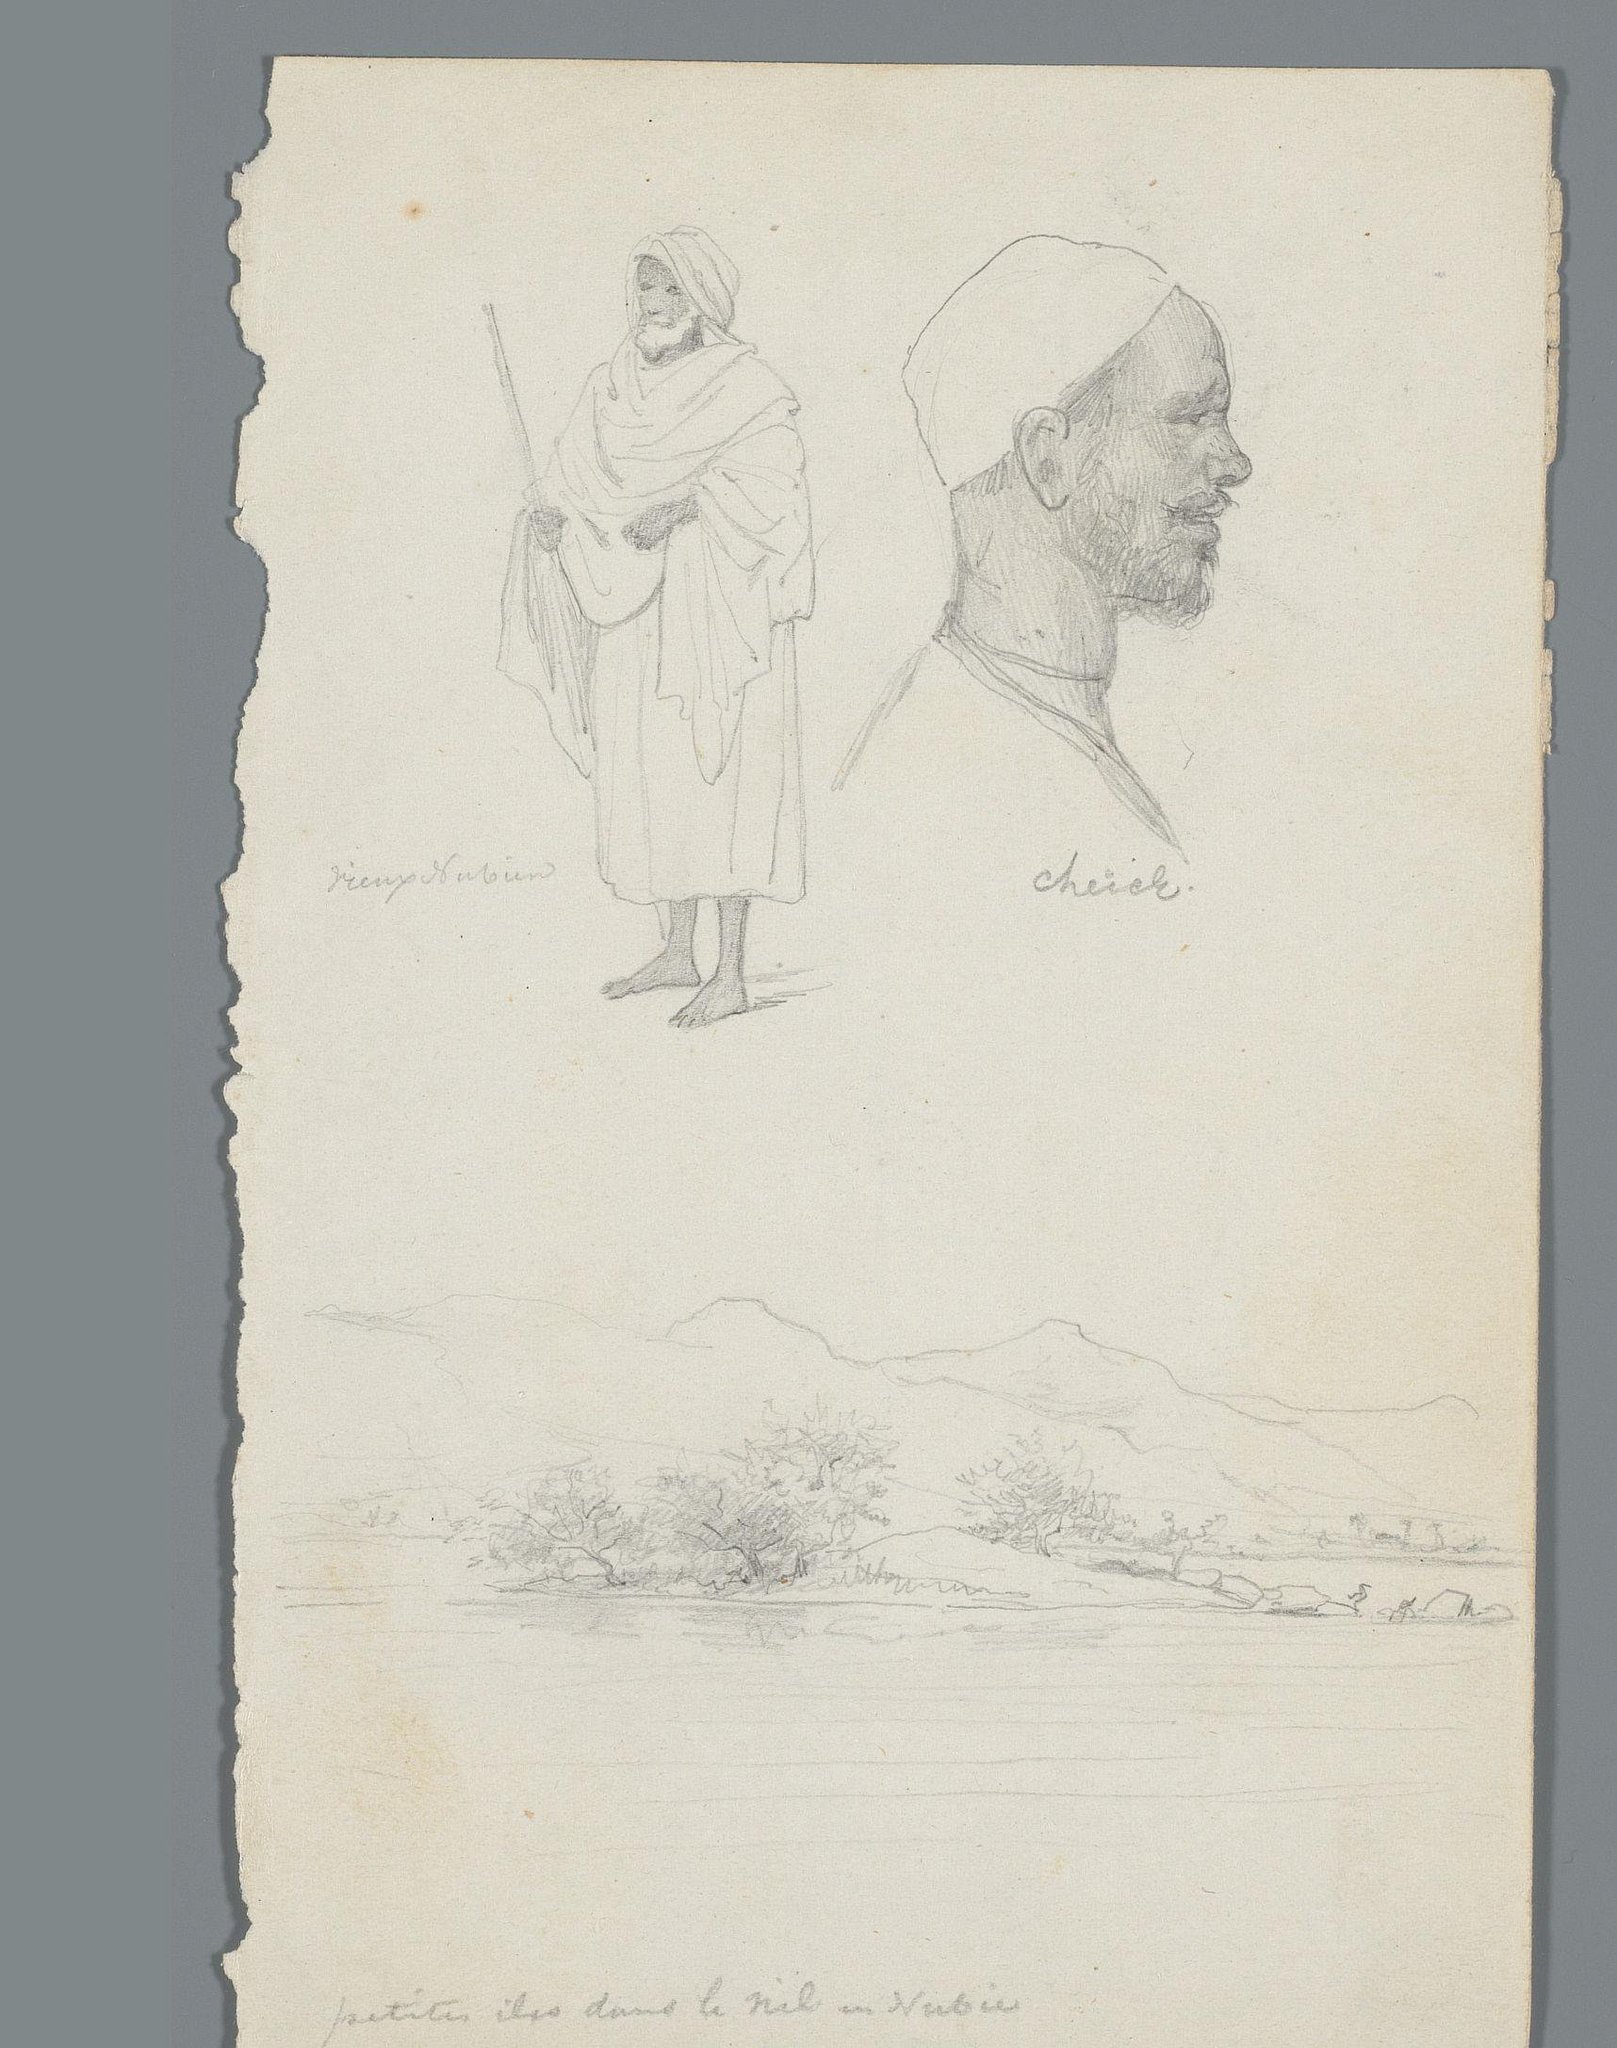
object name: drawing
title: Egyptische reis van 1858-1859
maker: willem de famars testas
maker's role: draughtsman, painter, print maker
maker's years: 1834-1896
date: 1858-1859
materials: paper, pencil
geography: egypt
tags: coast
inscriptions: inscription: ‘vieux Nubien / cheick / petites iles dans le Nil en Nubie’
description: Onderdeel van 20 losse bladen met tekeningen gemaakt tijdens Famars Testas zijn Egyptische reis van 1858, met voornamelijk figuren en dorpsgezichten met notities.